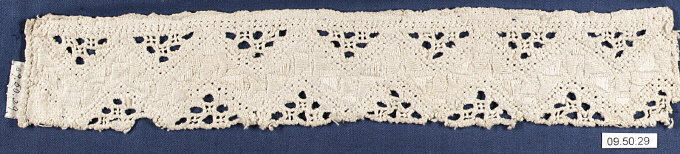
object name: strip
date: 1801-1900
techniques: embroidery